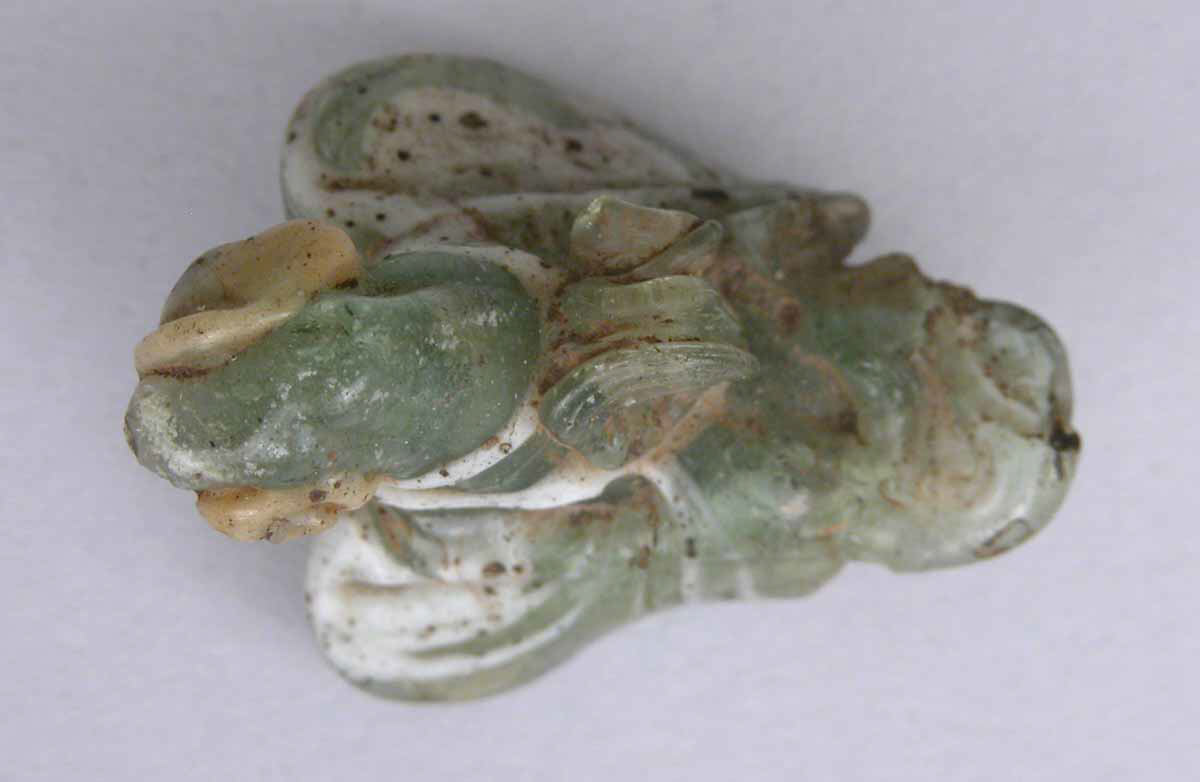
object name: pendant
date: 601-800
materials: glass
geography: syria